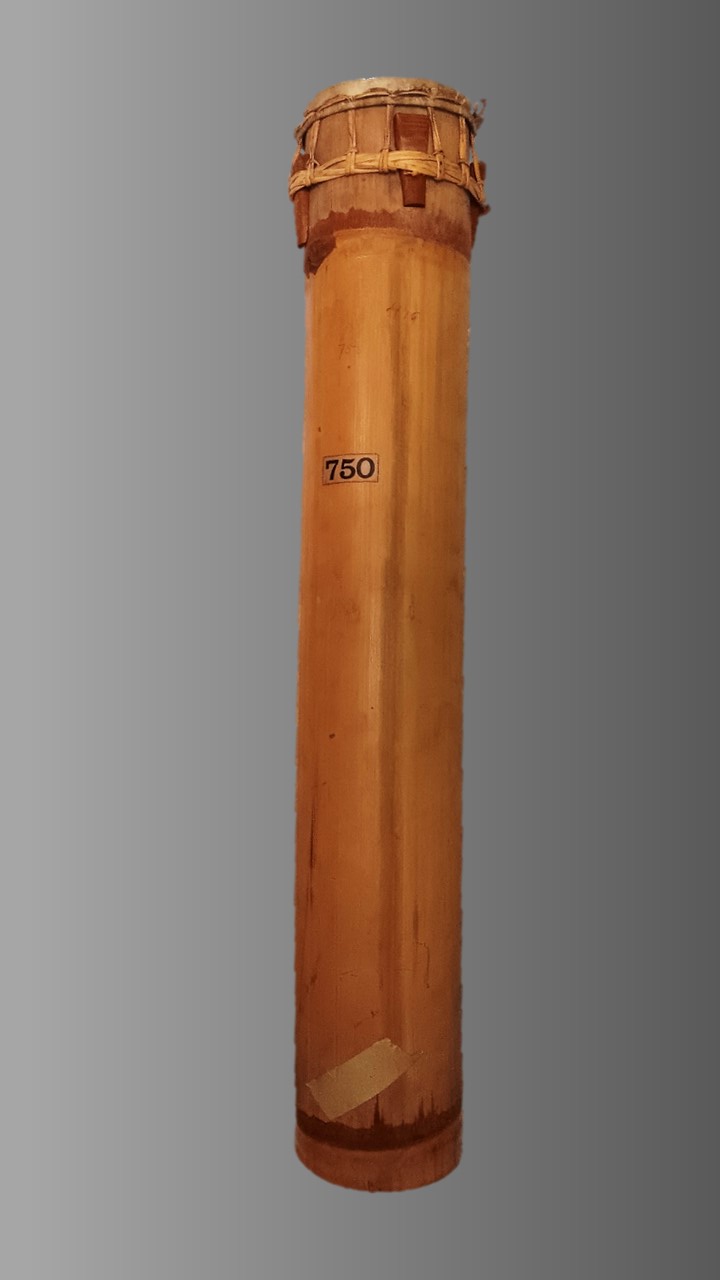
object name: dogdog lojor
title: Hand Drum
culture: javanese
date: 1867-1900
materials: bamboo, fiber, skin, wood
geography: indonesia